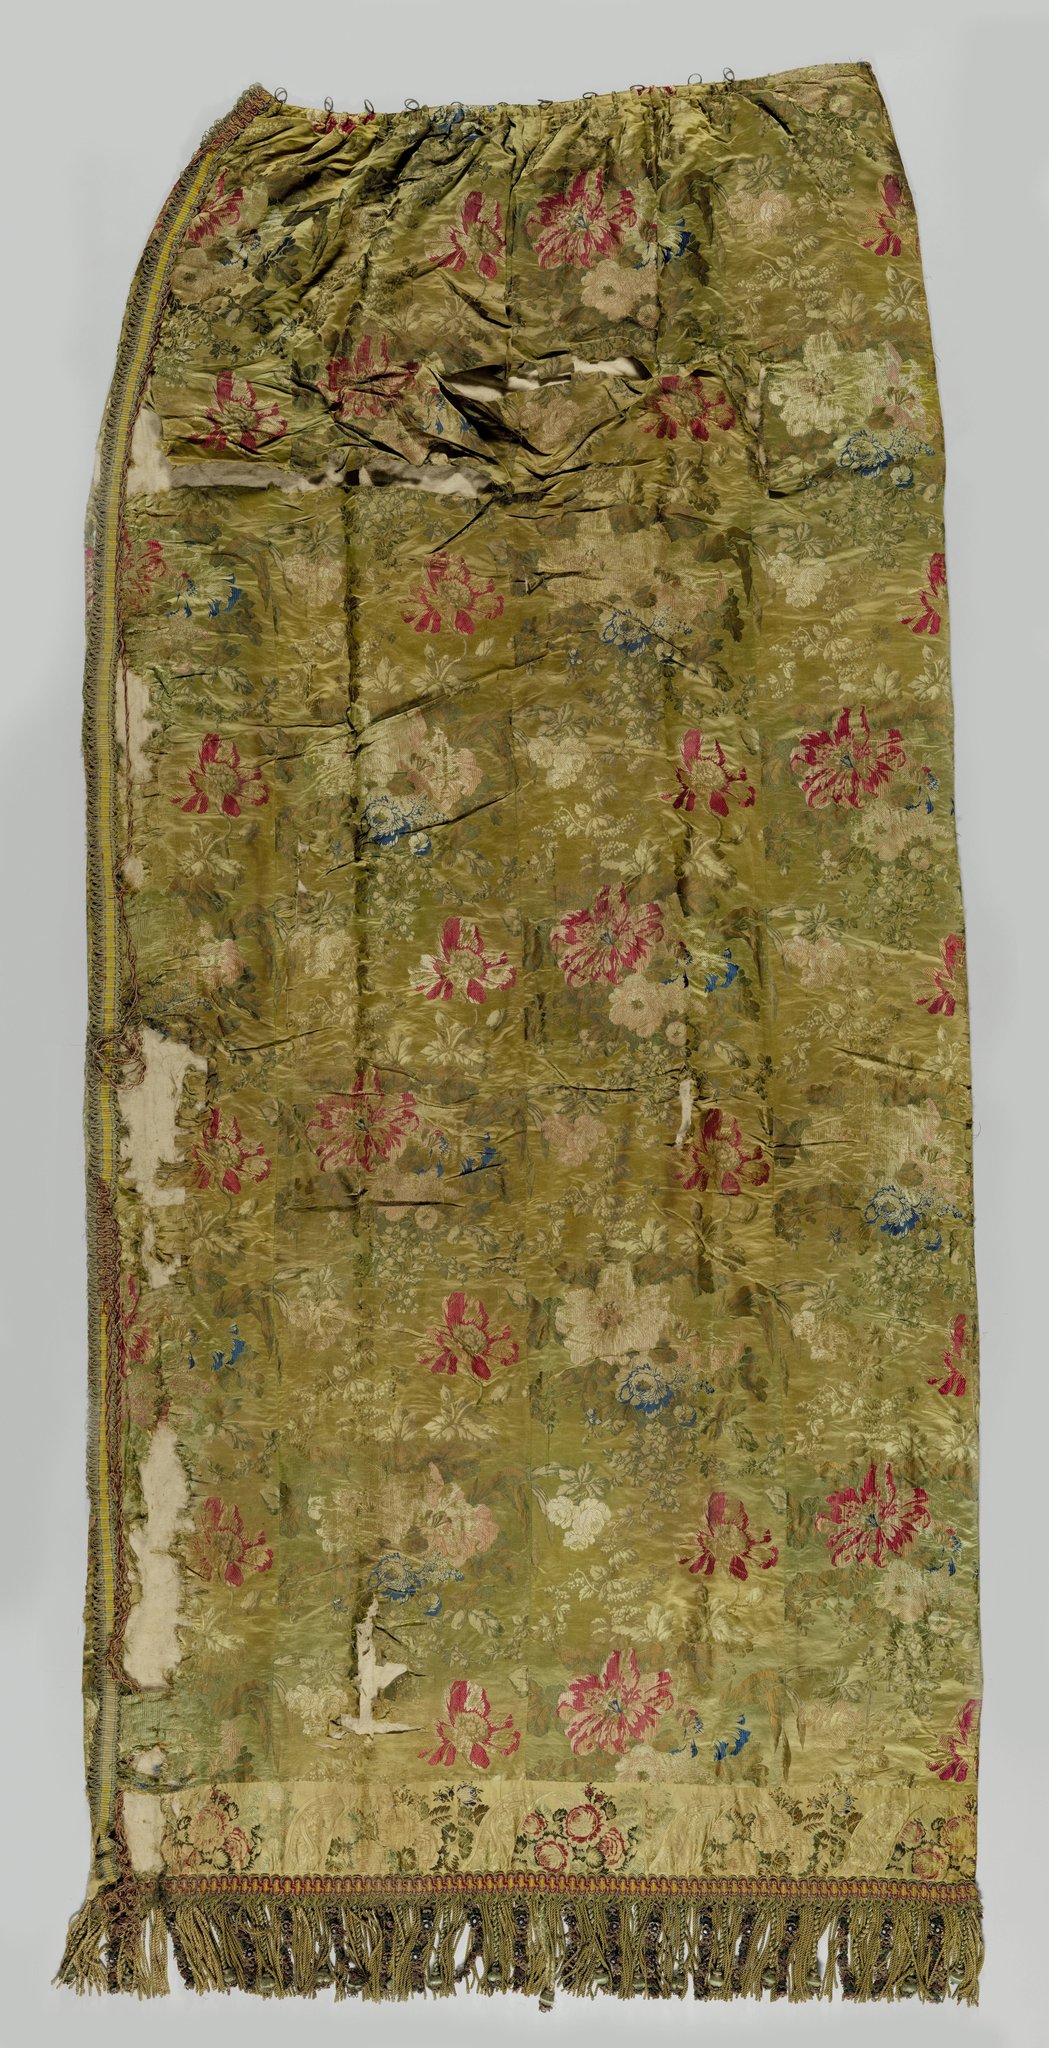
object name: silk textile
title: Gordijn met bloemdessin op geel fond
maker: carel hubertus windt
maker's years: 1804-1860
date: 1850-1860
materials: silk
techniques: lampas, weave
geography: the hague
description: Gordijn van zijde met bloemdessin op geel fond, afkomstig uit de kleine danszaal van Paleis Noordeinde.